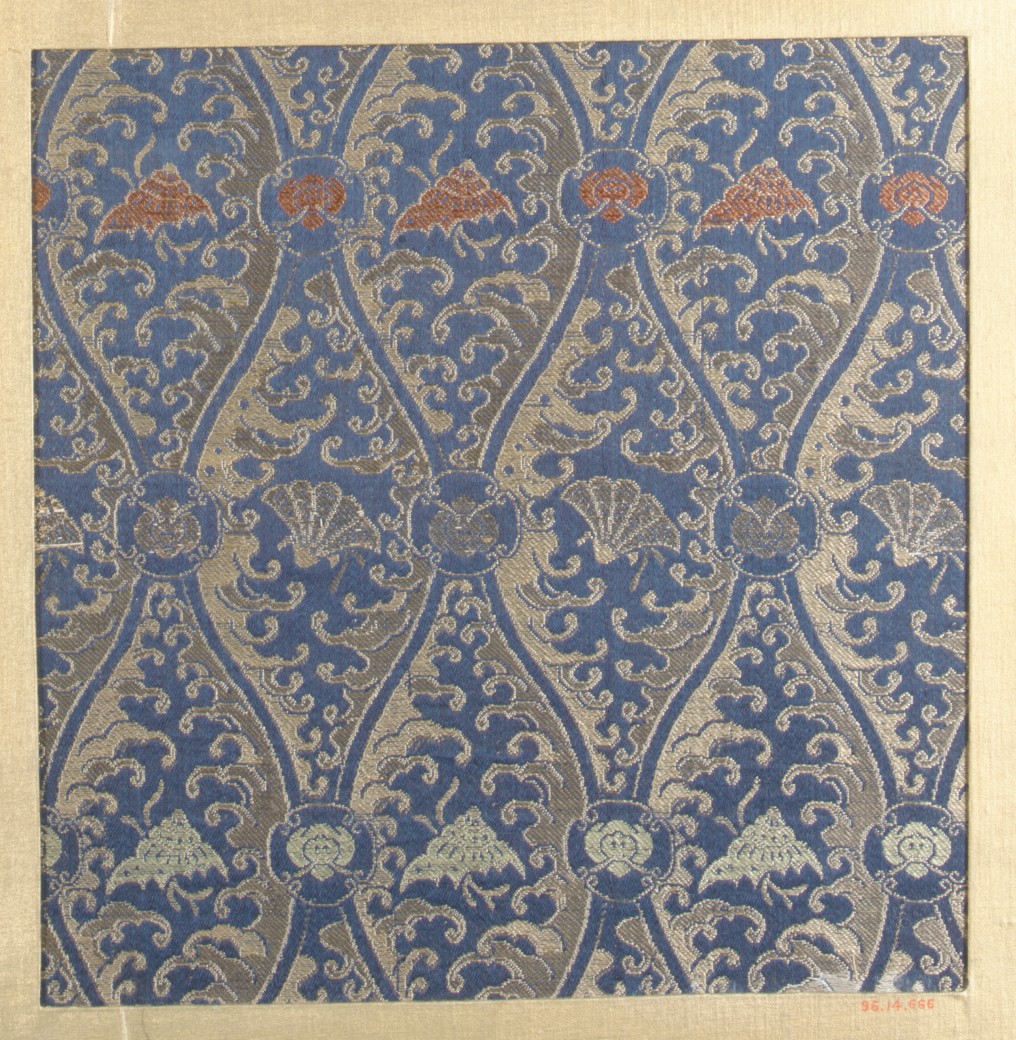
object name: piece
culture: japanese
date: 1701-1900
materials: silk